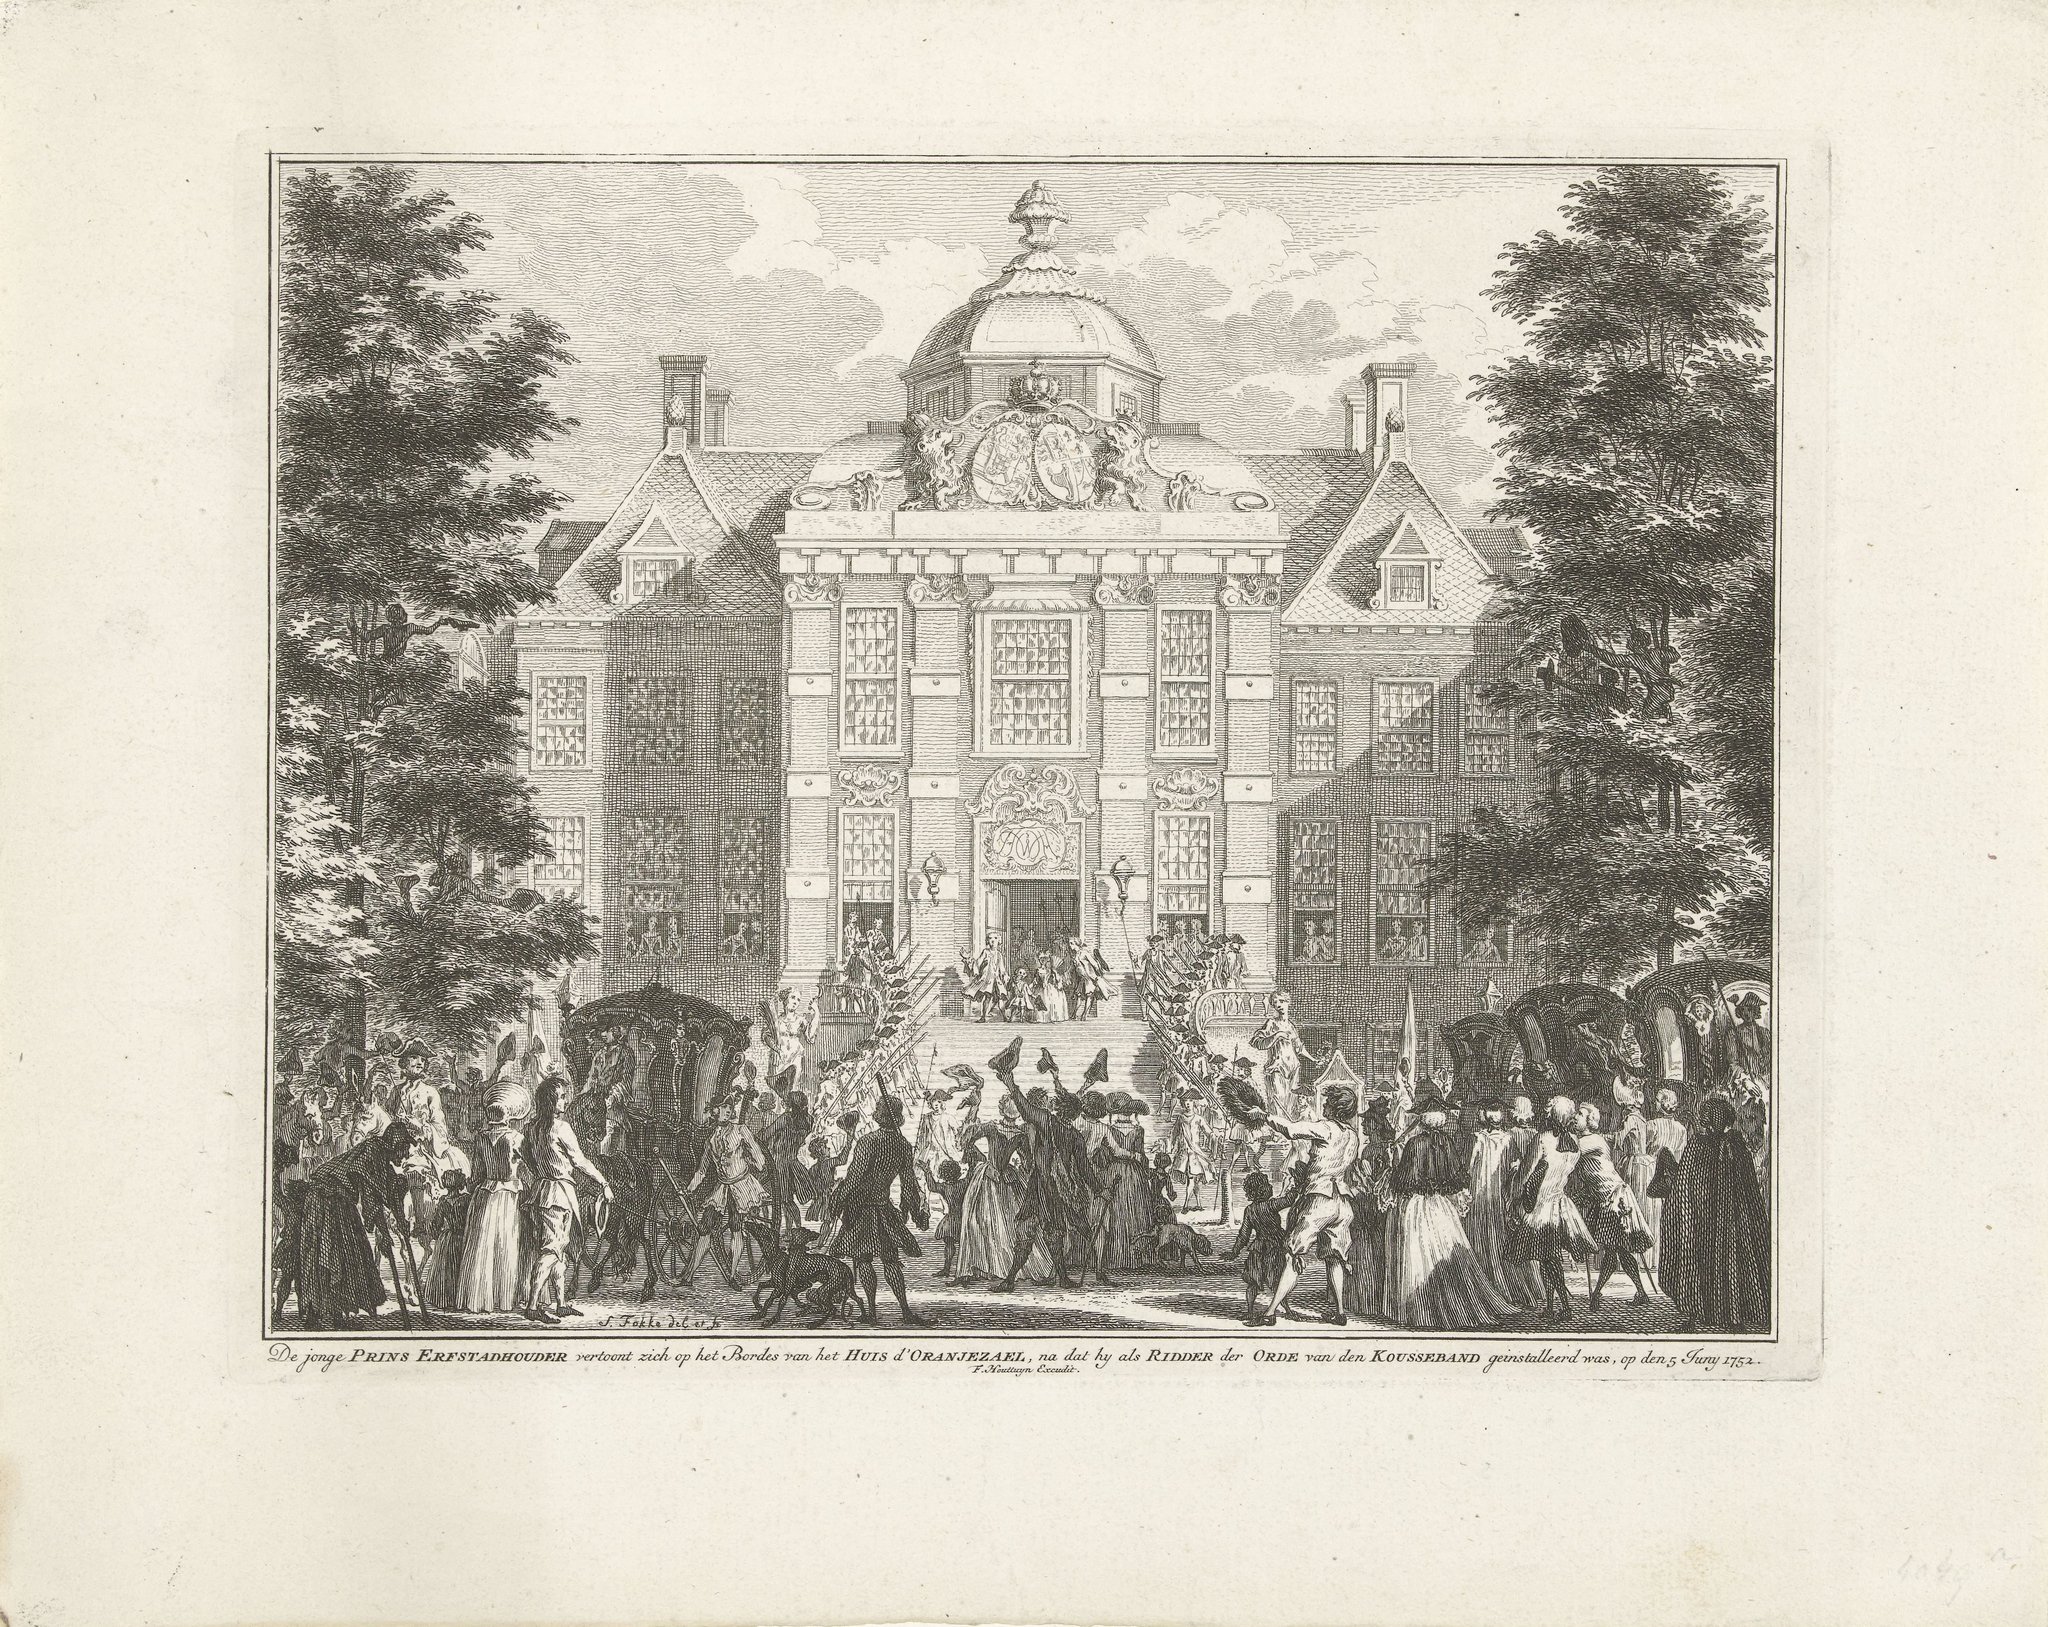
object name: print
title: De jonge Prins Erfstadhouder vertoont zich op het Bordes van het Huis d'Oranjezael, na dat hy als Ridder der Orde van den Kousseband geinstalleerd was, op den 5 Juny 1752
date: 1752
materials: paper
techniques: etching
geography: northern netherlands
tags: the hague, william v (prince of orange), knighthood order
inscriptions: collector's mark: Lugt 2228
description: De jonge prins Willem V vertoont zich na zijn installatie als Ridder in de Orde van de Kousenband op het bordes van Paleis Huis Ten Bosch, 5 juni 1752. Op de straat voor het paleis wordt hij toegejuichd door een verzameld menigte.